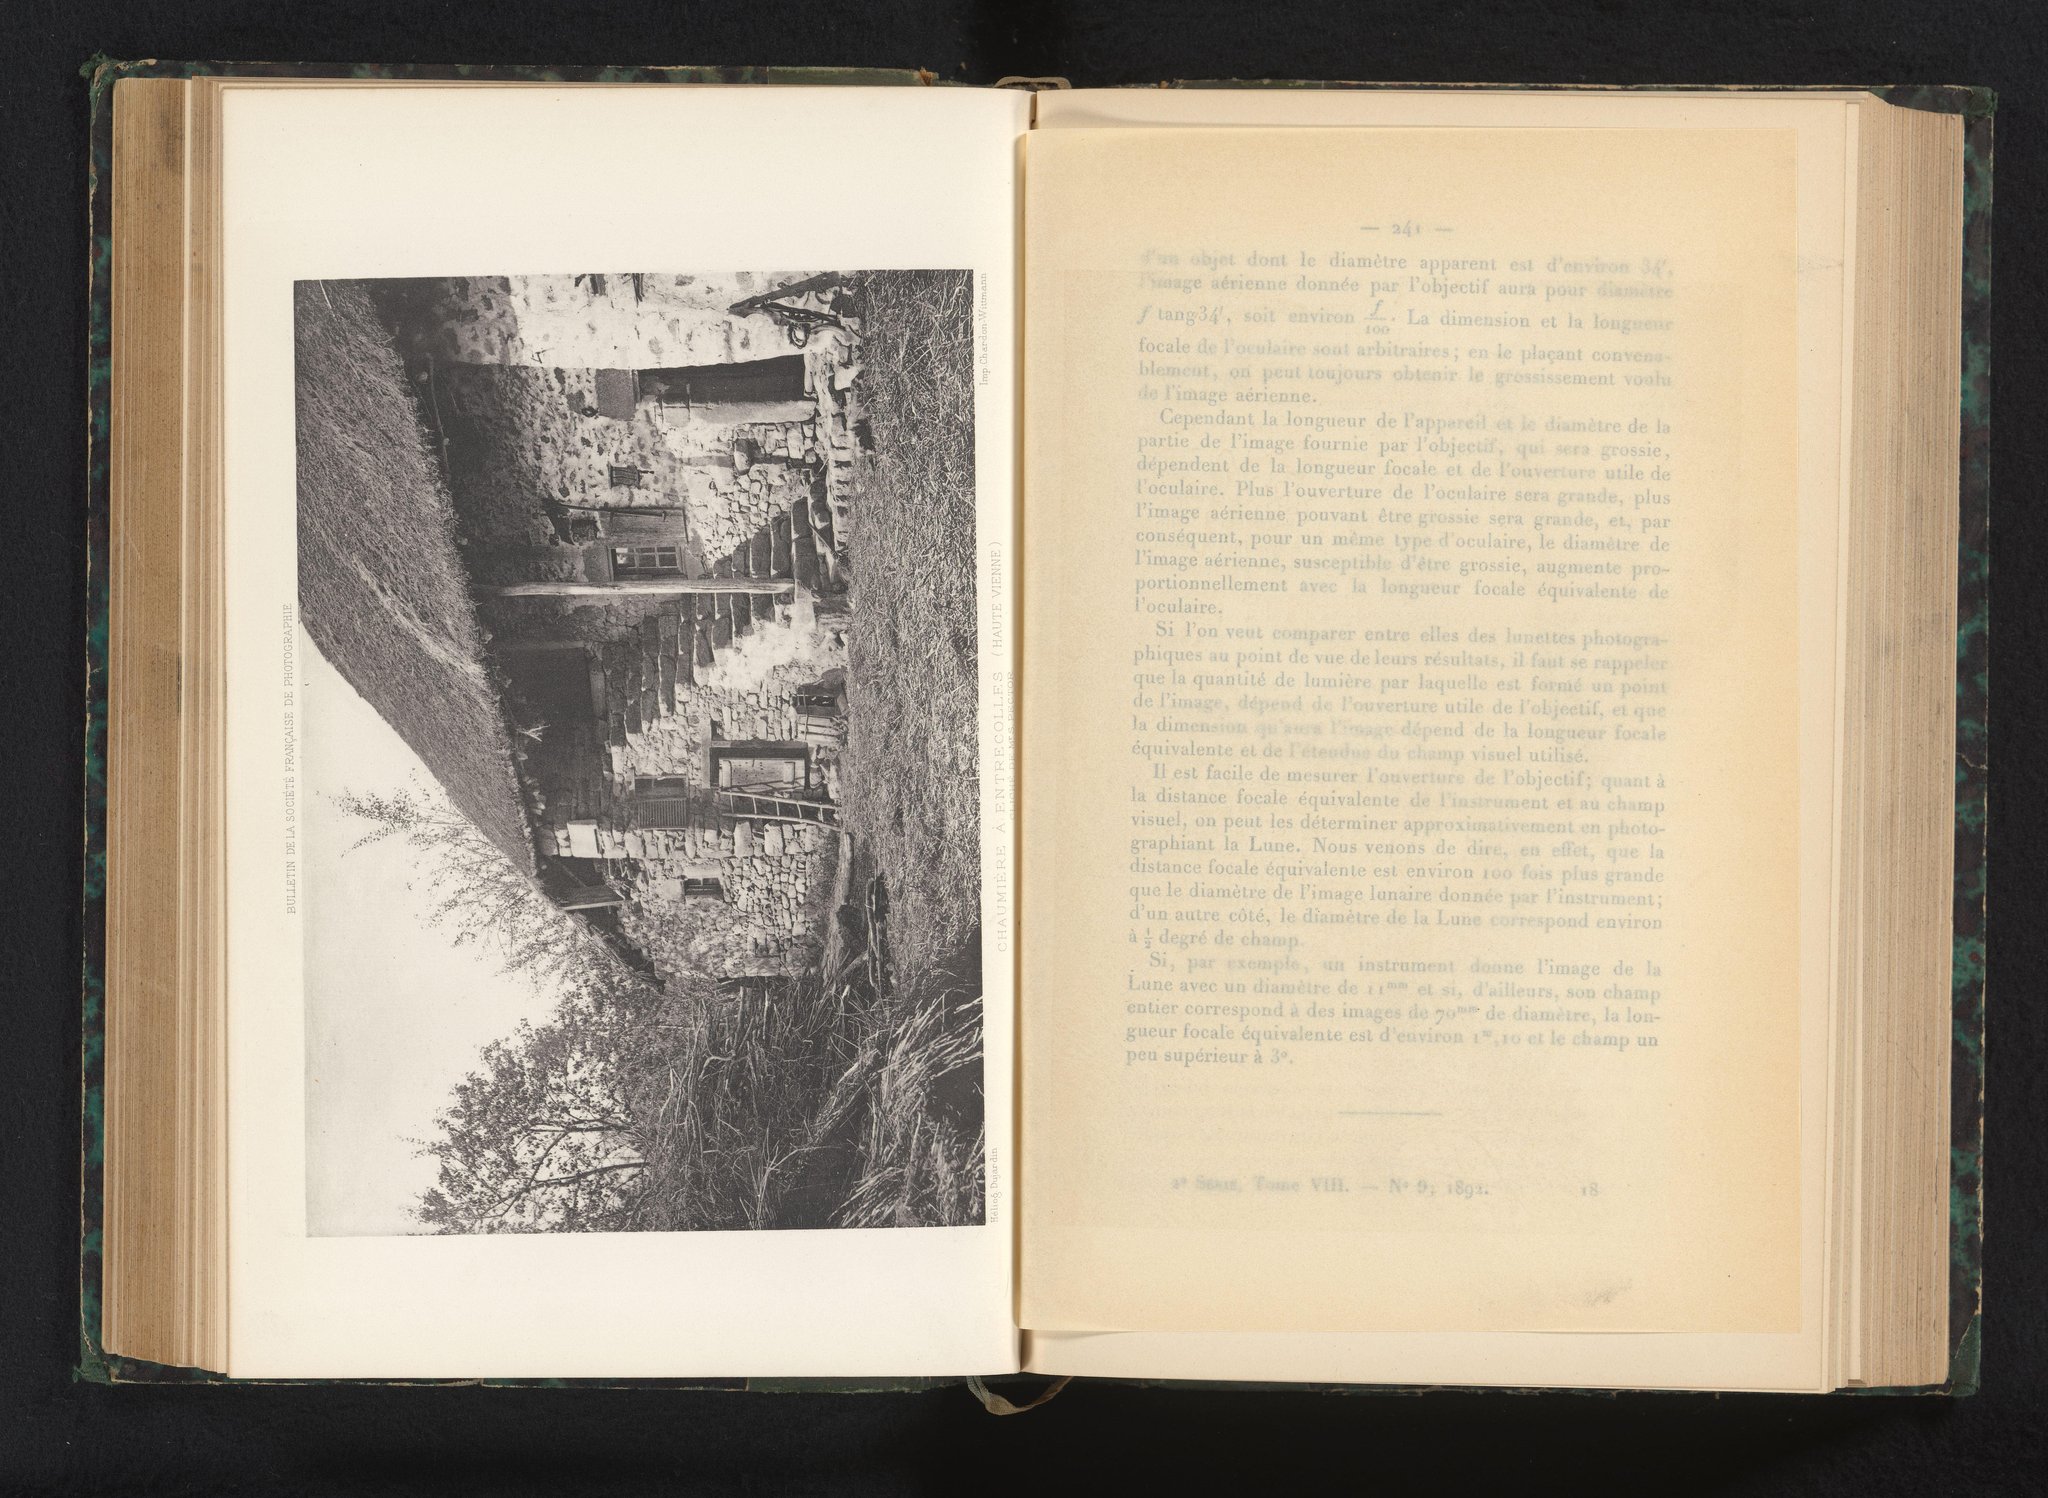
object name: page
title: Boerderij in Entrecolles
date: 1887-1892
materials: paper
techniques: photoaquatint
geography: paris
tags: farm (building)